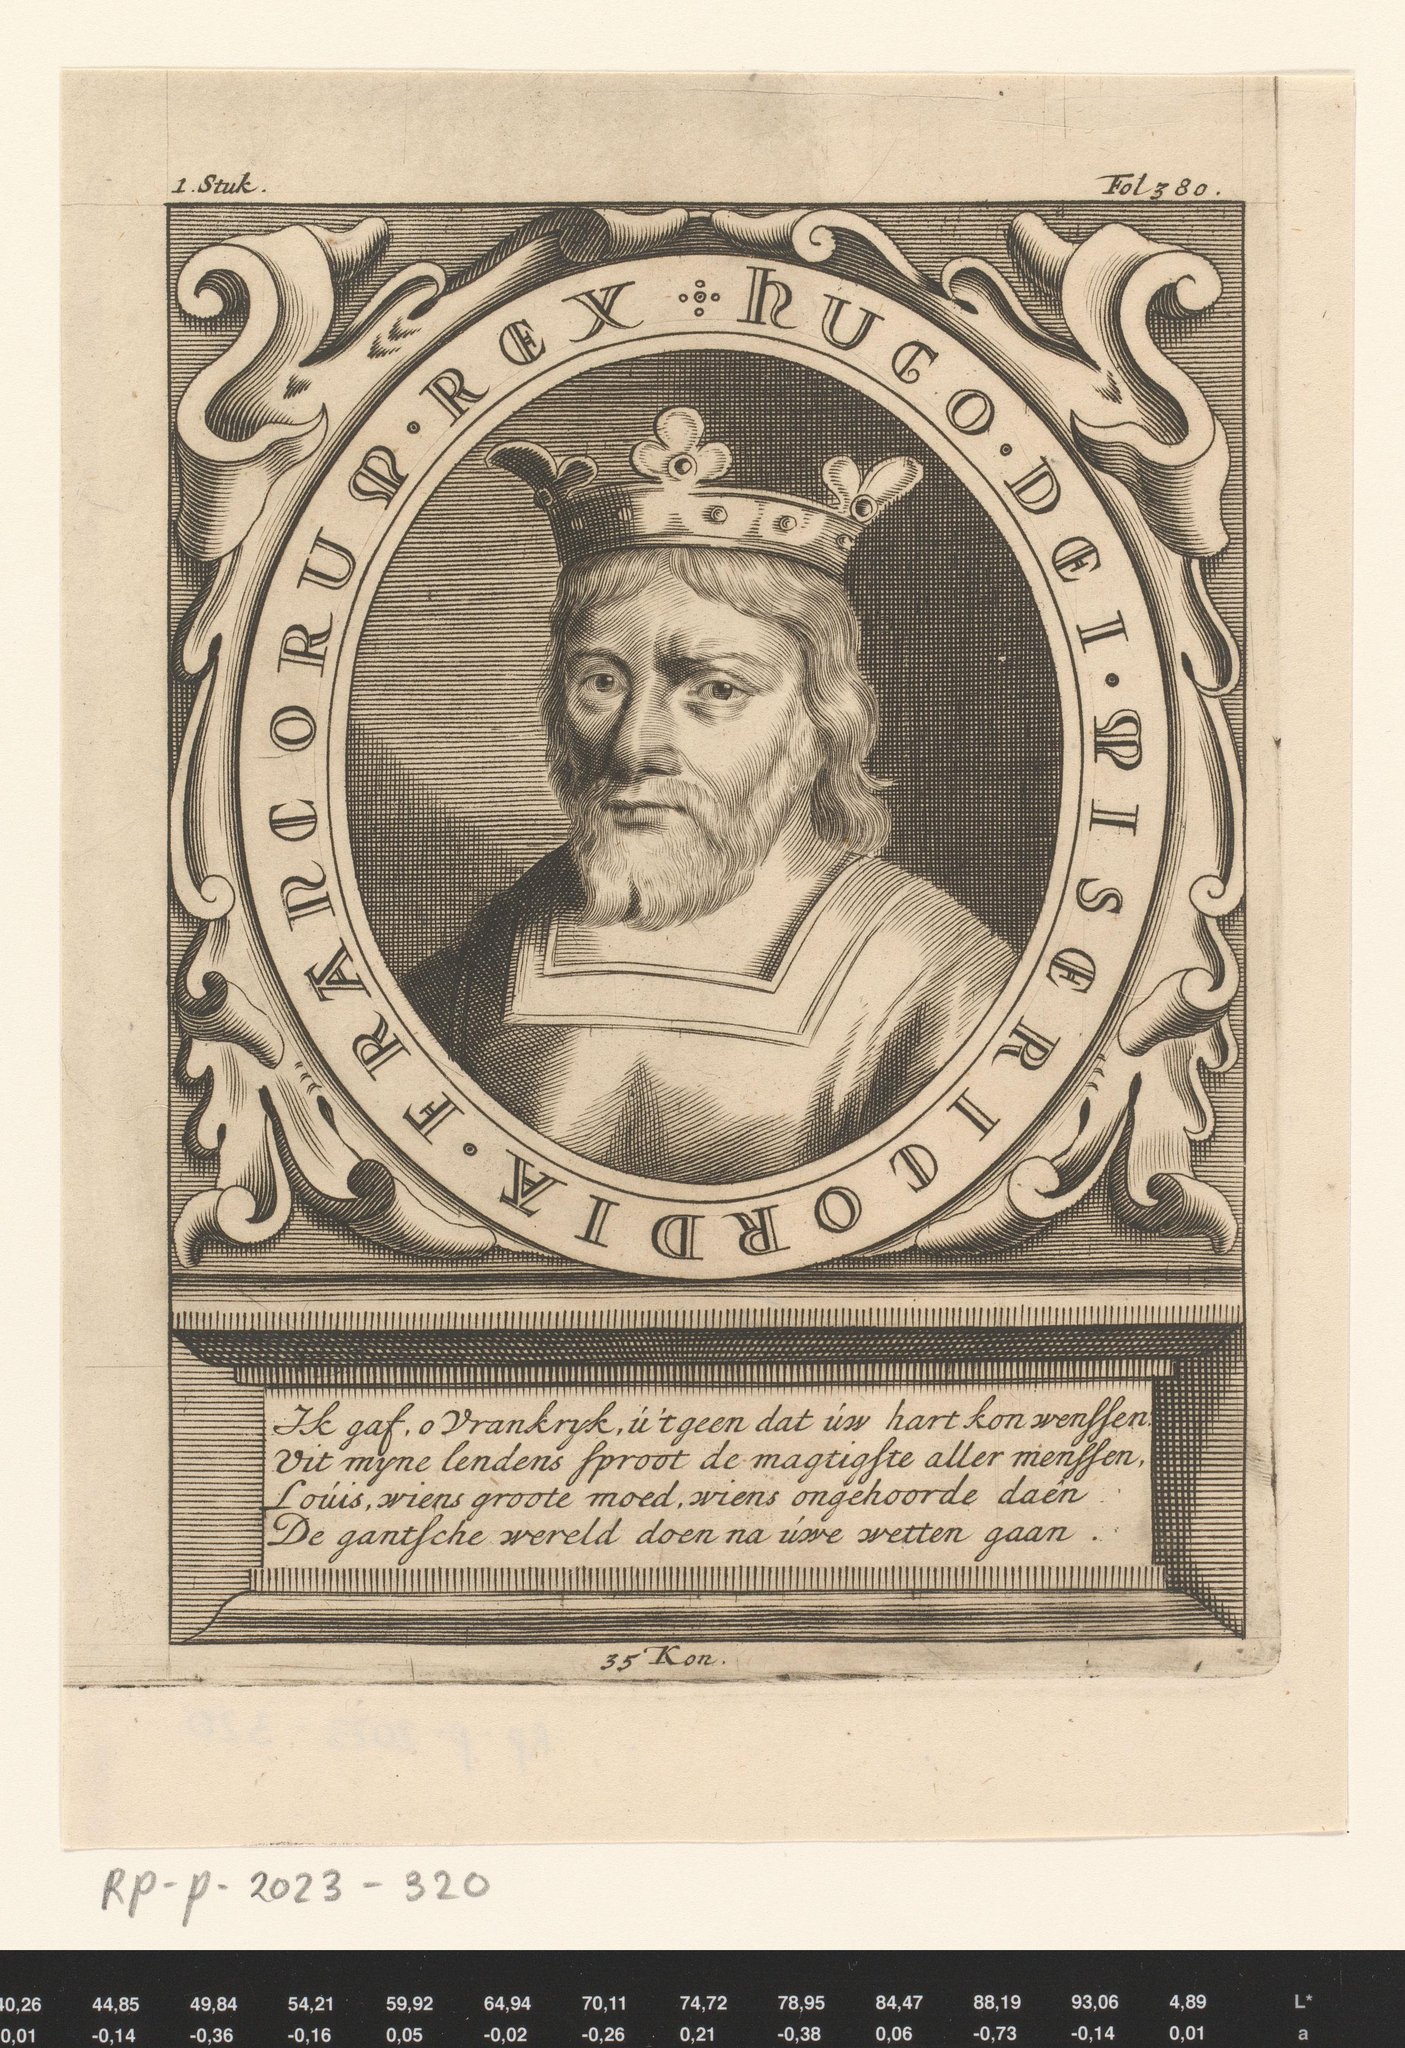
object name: print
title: Portret van Hugo Capet van Frankrijk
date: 1685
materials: paper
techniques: engraving, etching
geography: amsterdam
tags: historical persons, king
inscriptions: collector's mark: Lugt 2228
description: Prent uit: Mézeray, François Eudes de. Chronyk van Vrankryk. [Vertaald uit het Frans door] G. v. Broekhuizen. Amsterdam: Timotheus ten Hoorn en Jan Bouman, 1685, dl. 1, p. 380.